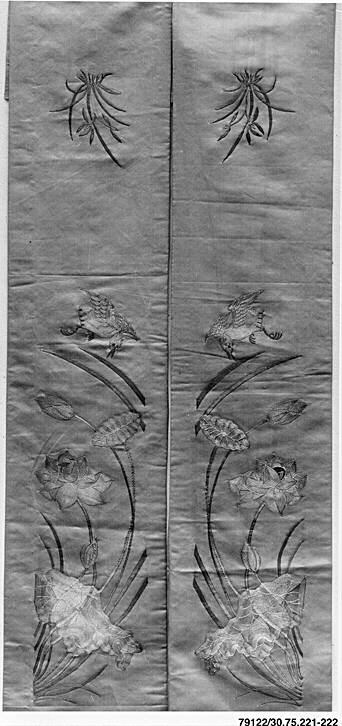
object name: sleeve band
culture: chinese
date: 1801-1900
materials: metal thread, silk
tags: birds